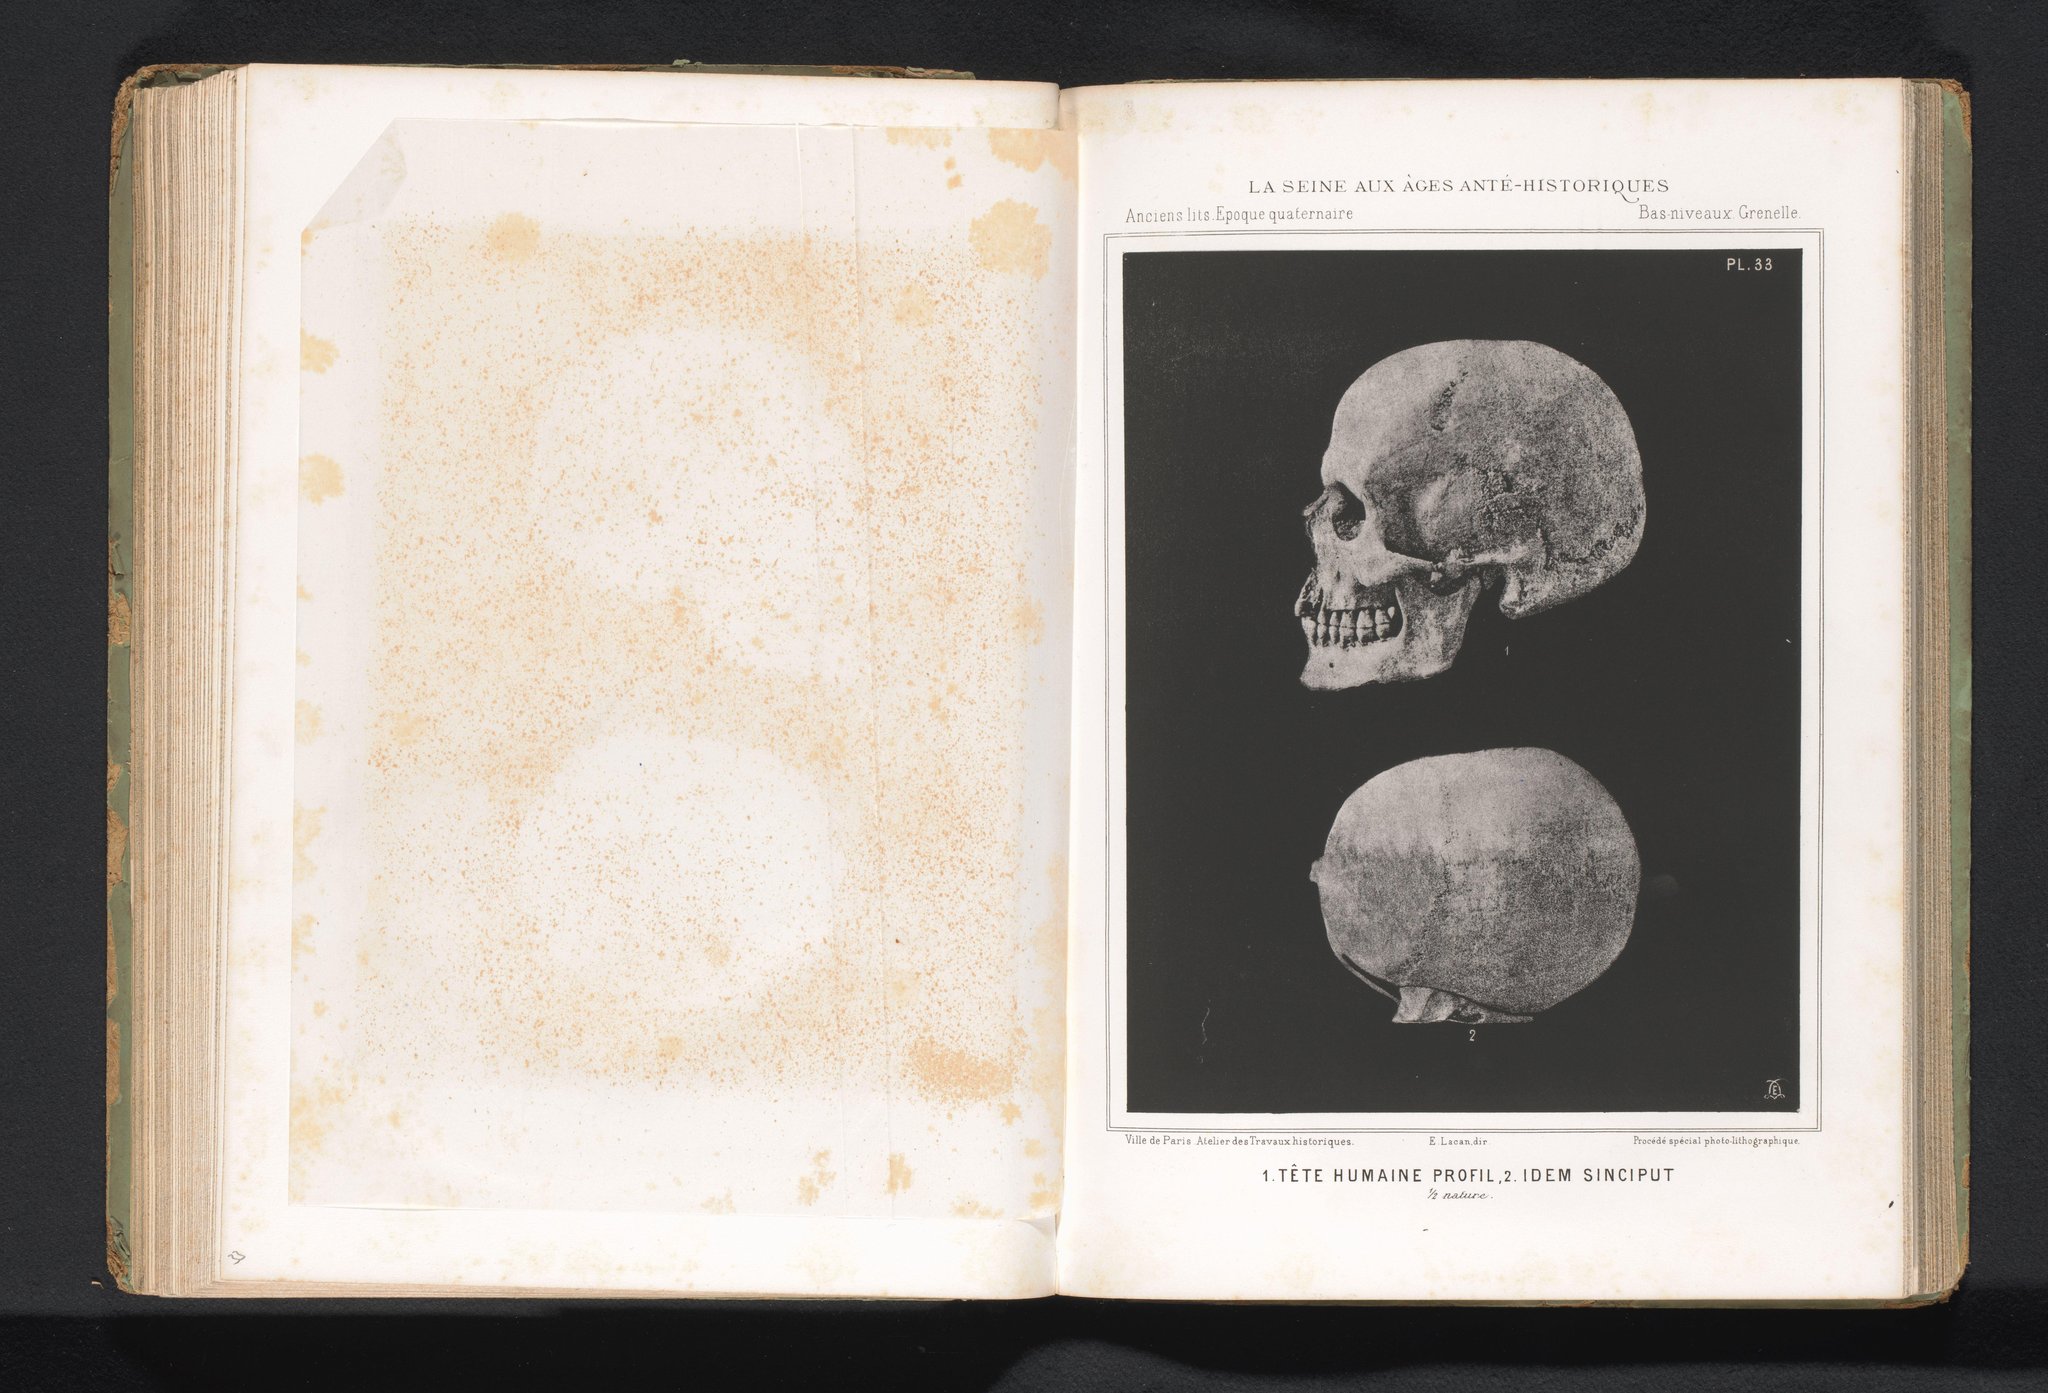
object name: photomechanical print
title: Twee aanzichten van een menselijke schedel, en profil en bovenaanzicht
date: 1864-1869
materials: paper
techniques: photolithography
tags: (human) skull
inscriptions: inscription: ‘1. TÊTE HUMAINE PROFIL, 2. IDEM SINCIPUT’, inscription: ‘PL. 33’, inscription: ‘Procédé spécial photo-lithographique’, inscription: ‘1/2 nature’, monogram: ‘E’